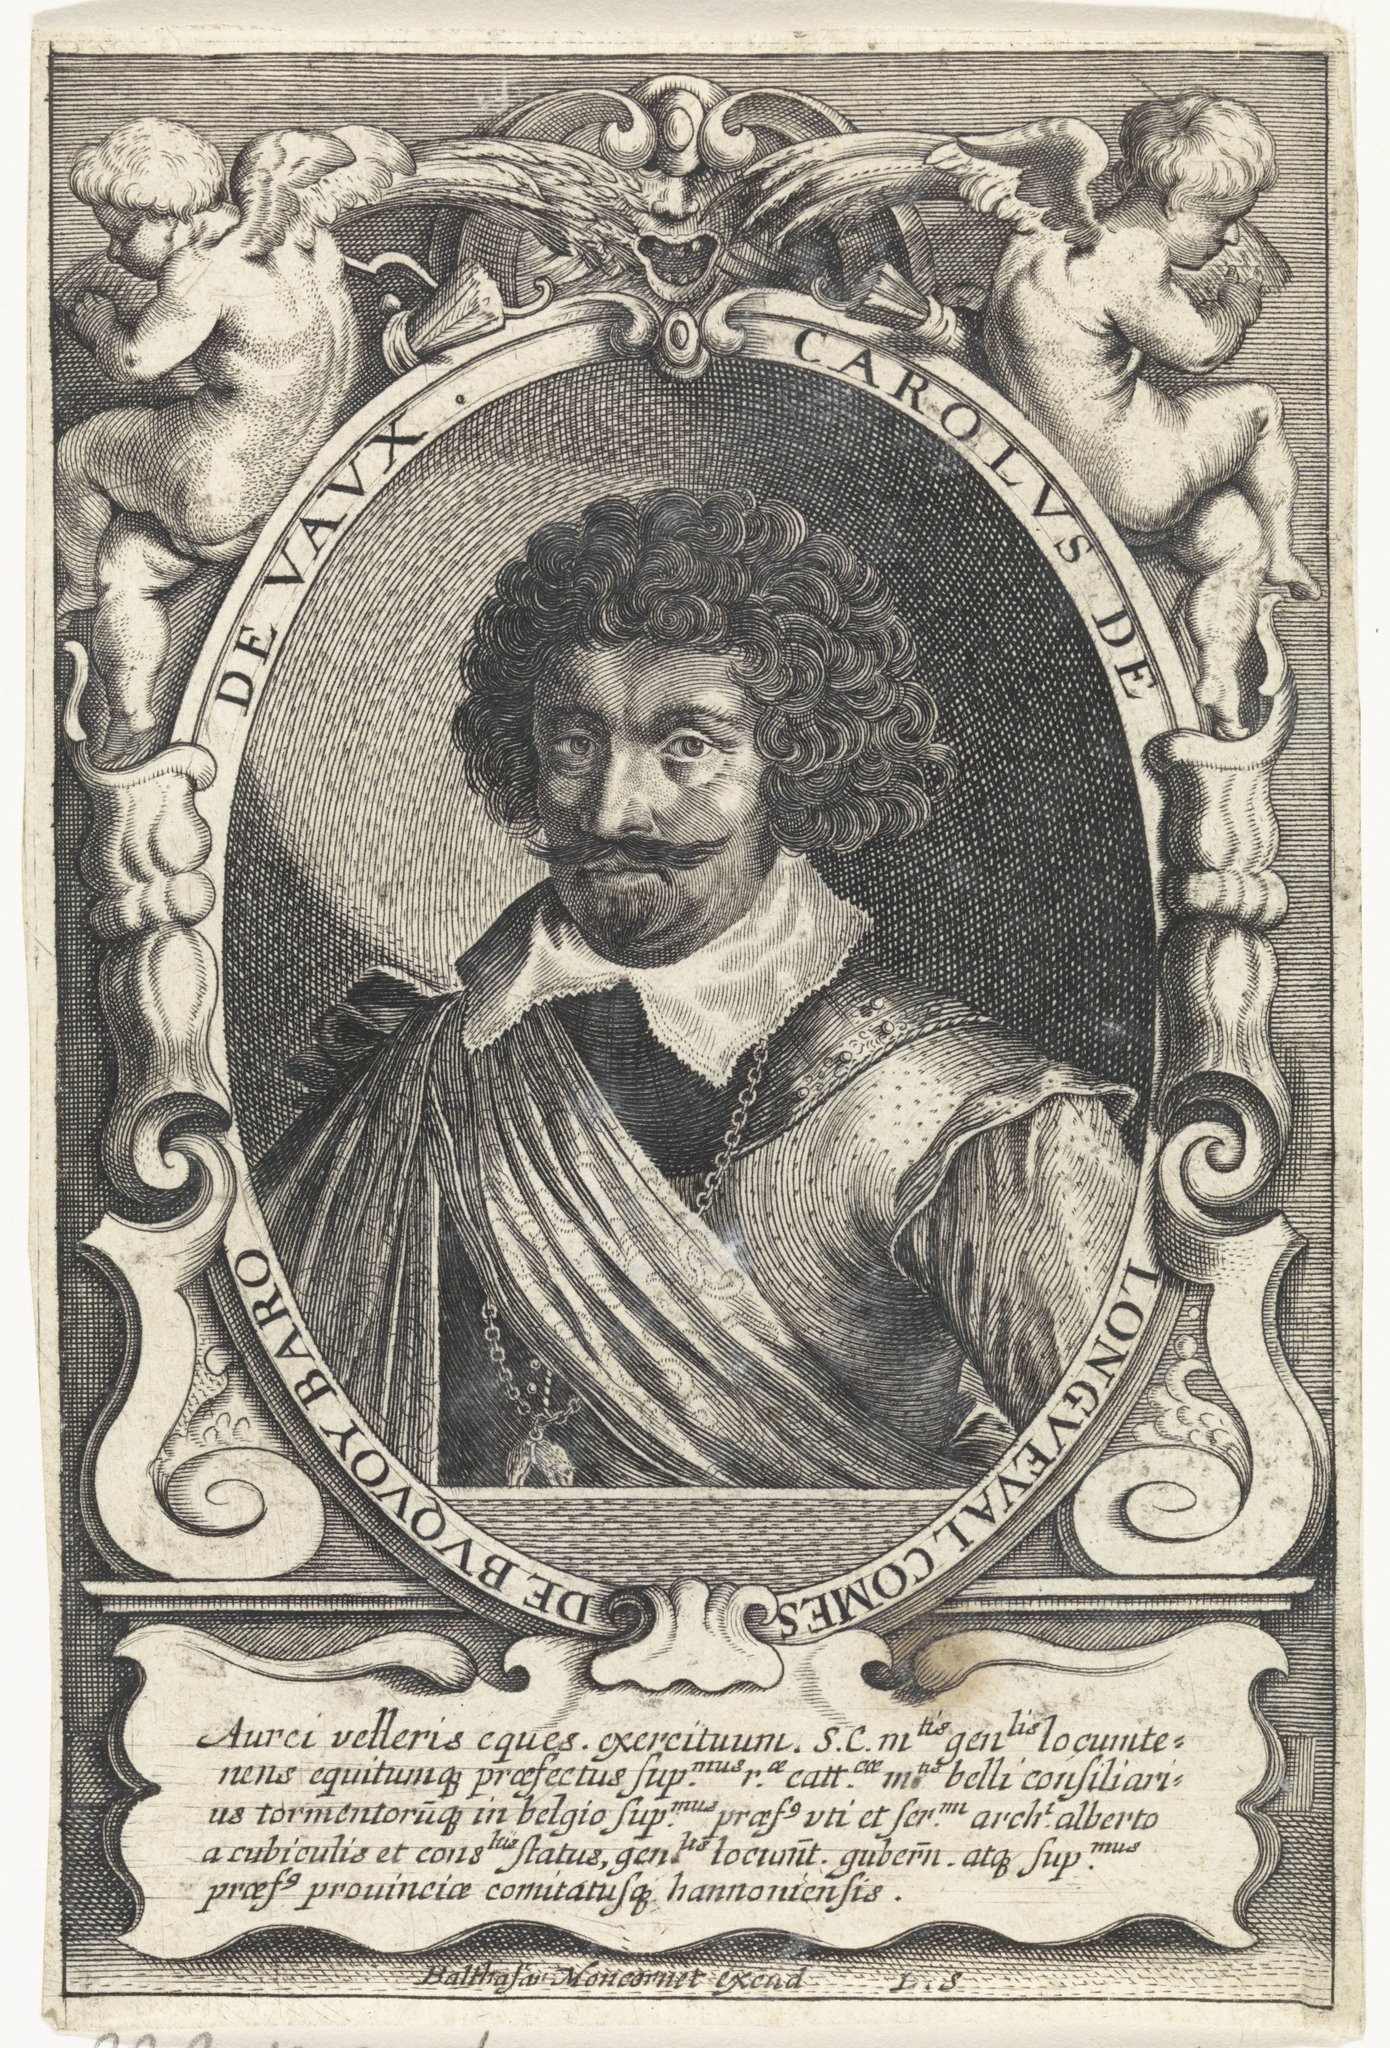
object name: print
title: Portret van Karel Bonaventura van Longueval, graaf van Bucquoy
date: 1606-1669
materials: paper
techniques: engraving, etching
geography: france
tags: arras, nové zámky, bevelhebber, karel bonaventura van longueval (graaf van bucquoy)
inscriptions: collector's mark: Lugt 2228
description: Portret van Karel Bonaventura van Longueval, graaf van Bucquoy, in een ornamentele omlijsting met in de bovenhoeken engeltjes. Onder het portret een vijfregelige tekst in het Frans.